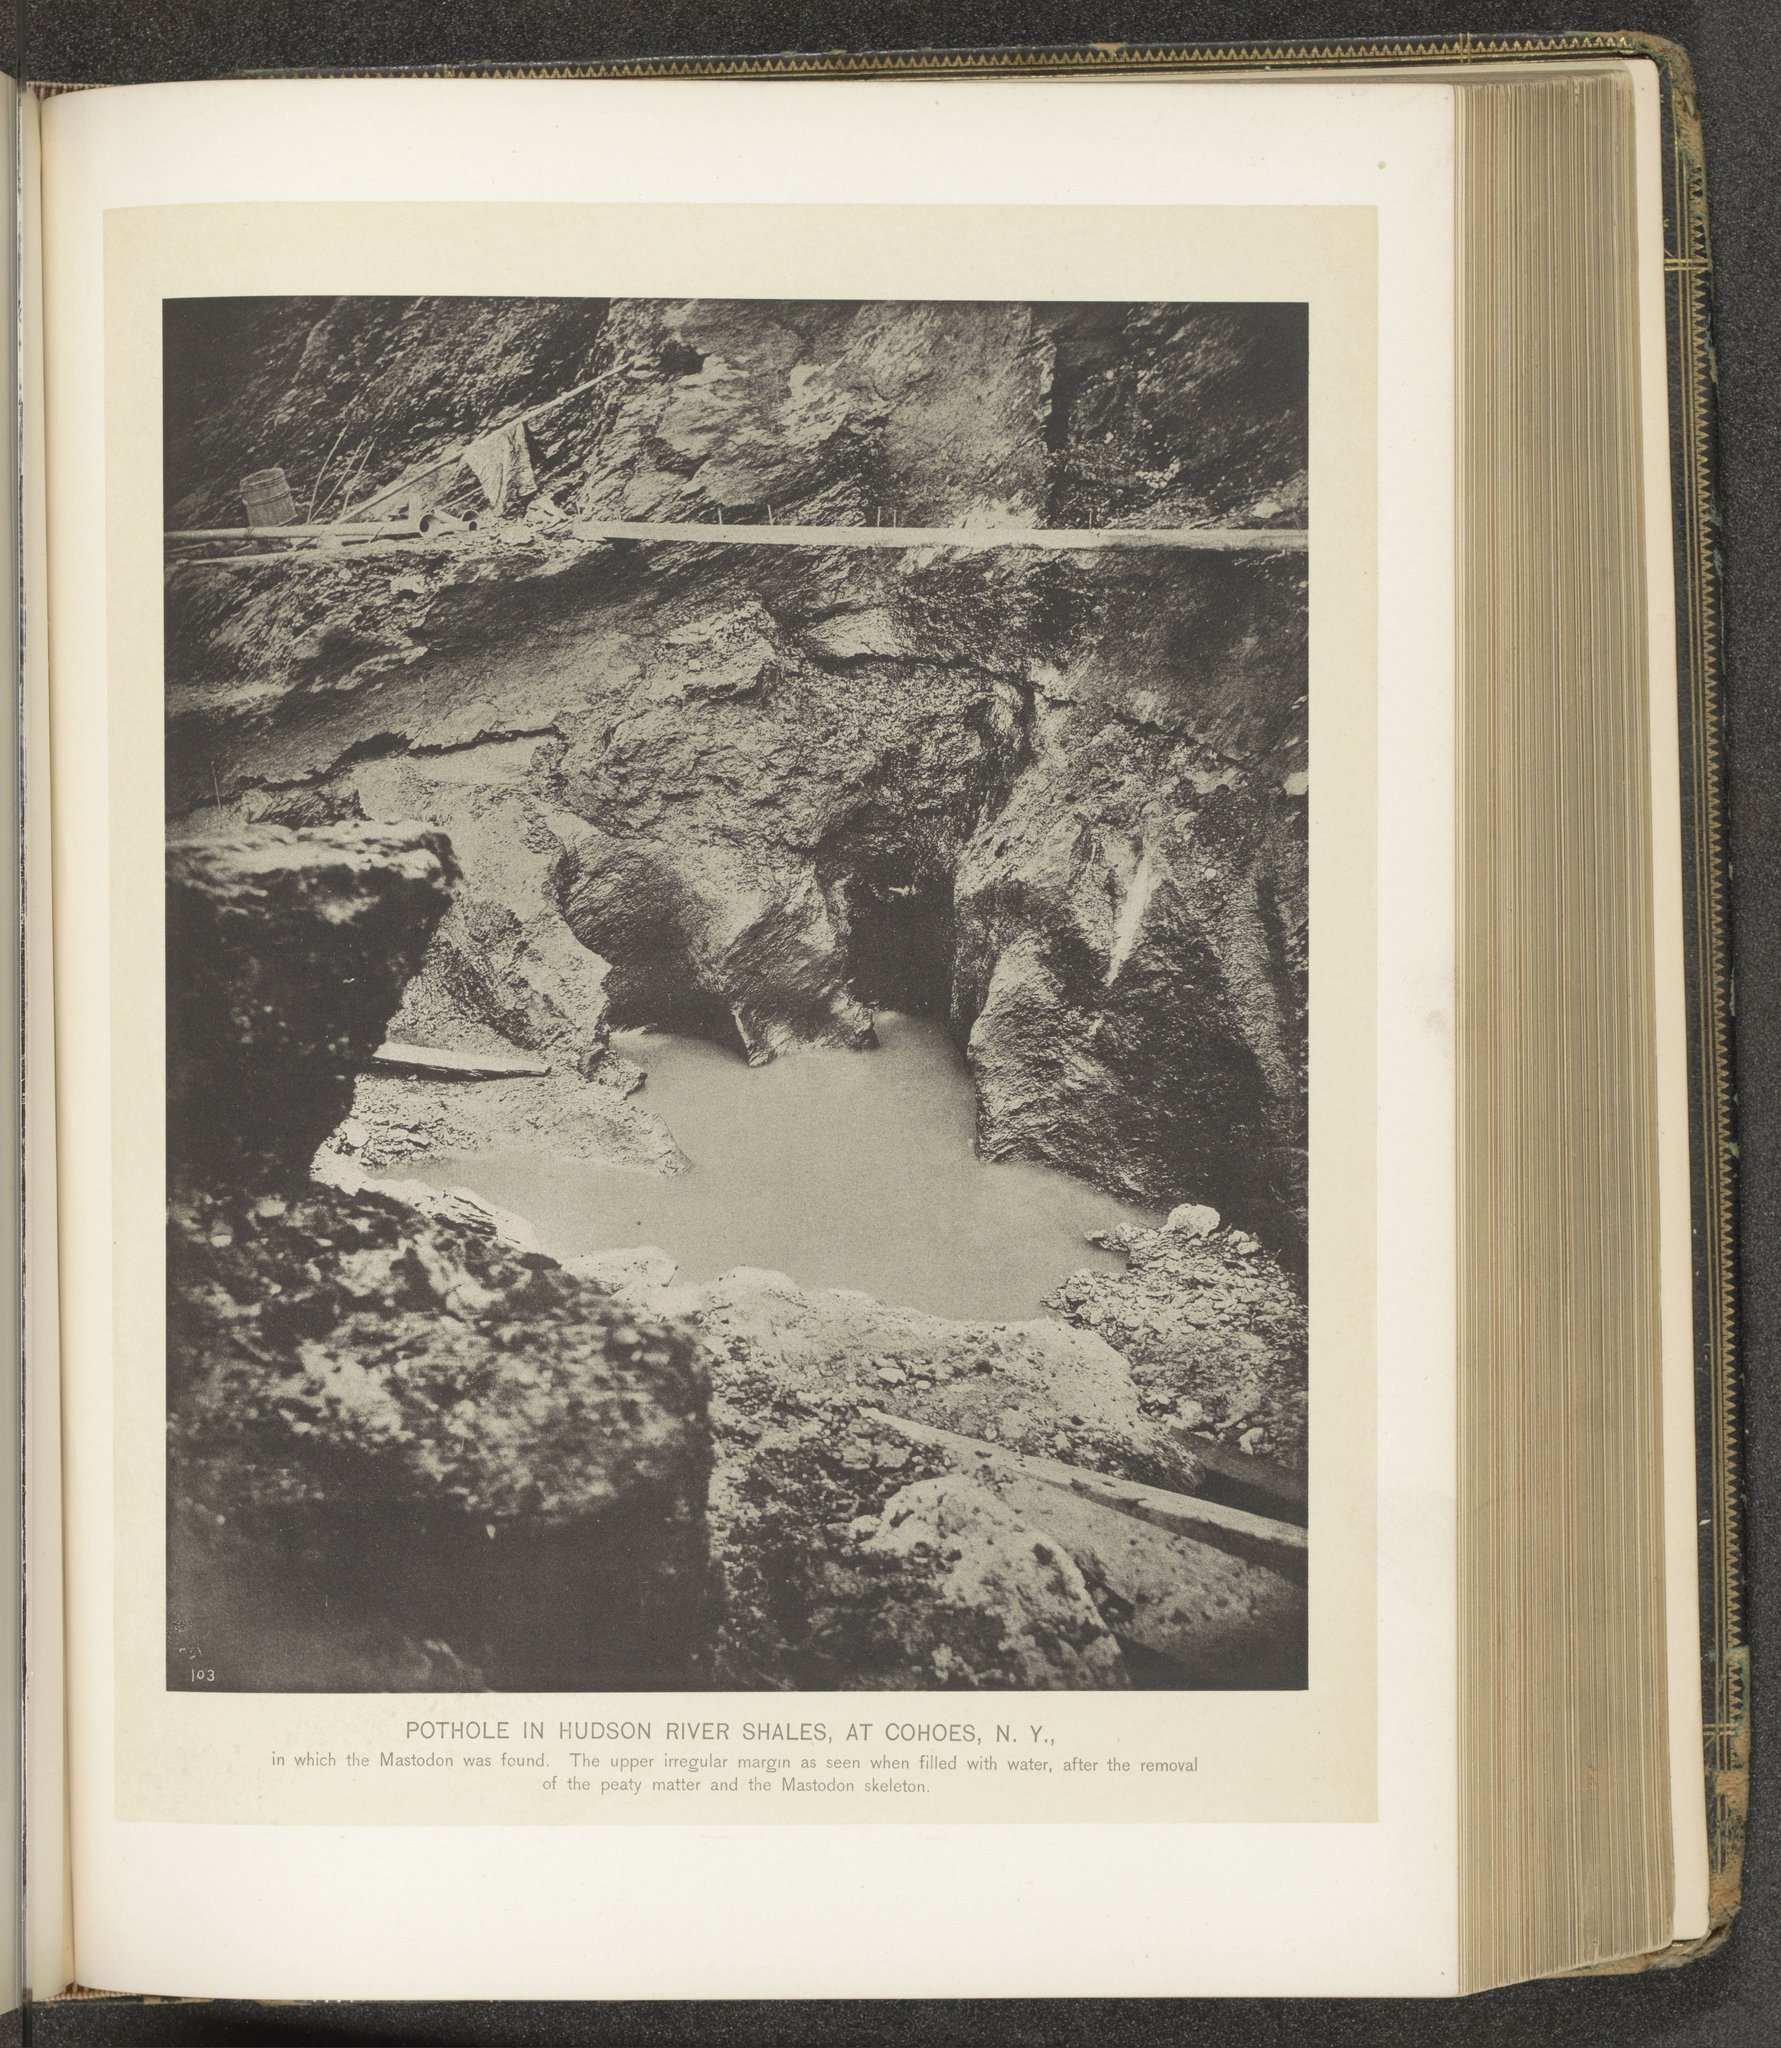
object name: page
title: Pothole in Hudson River shales, at Cohoes, N. Y.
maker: Anonymous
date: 1872-1882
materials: paper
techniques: photograph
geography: united states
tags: river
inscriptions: inscription: ‘in which the Mastodon was found (...) and the Mastodon skeleton.’, number: ‘103’